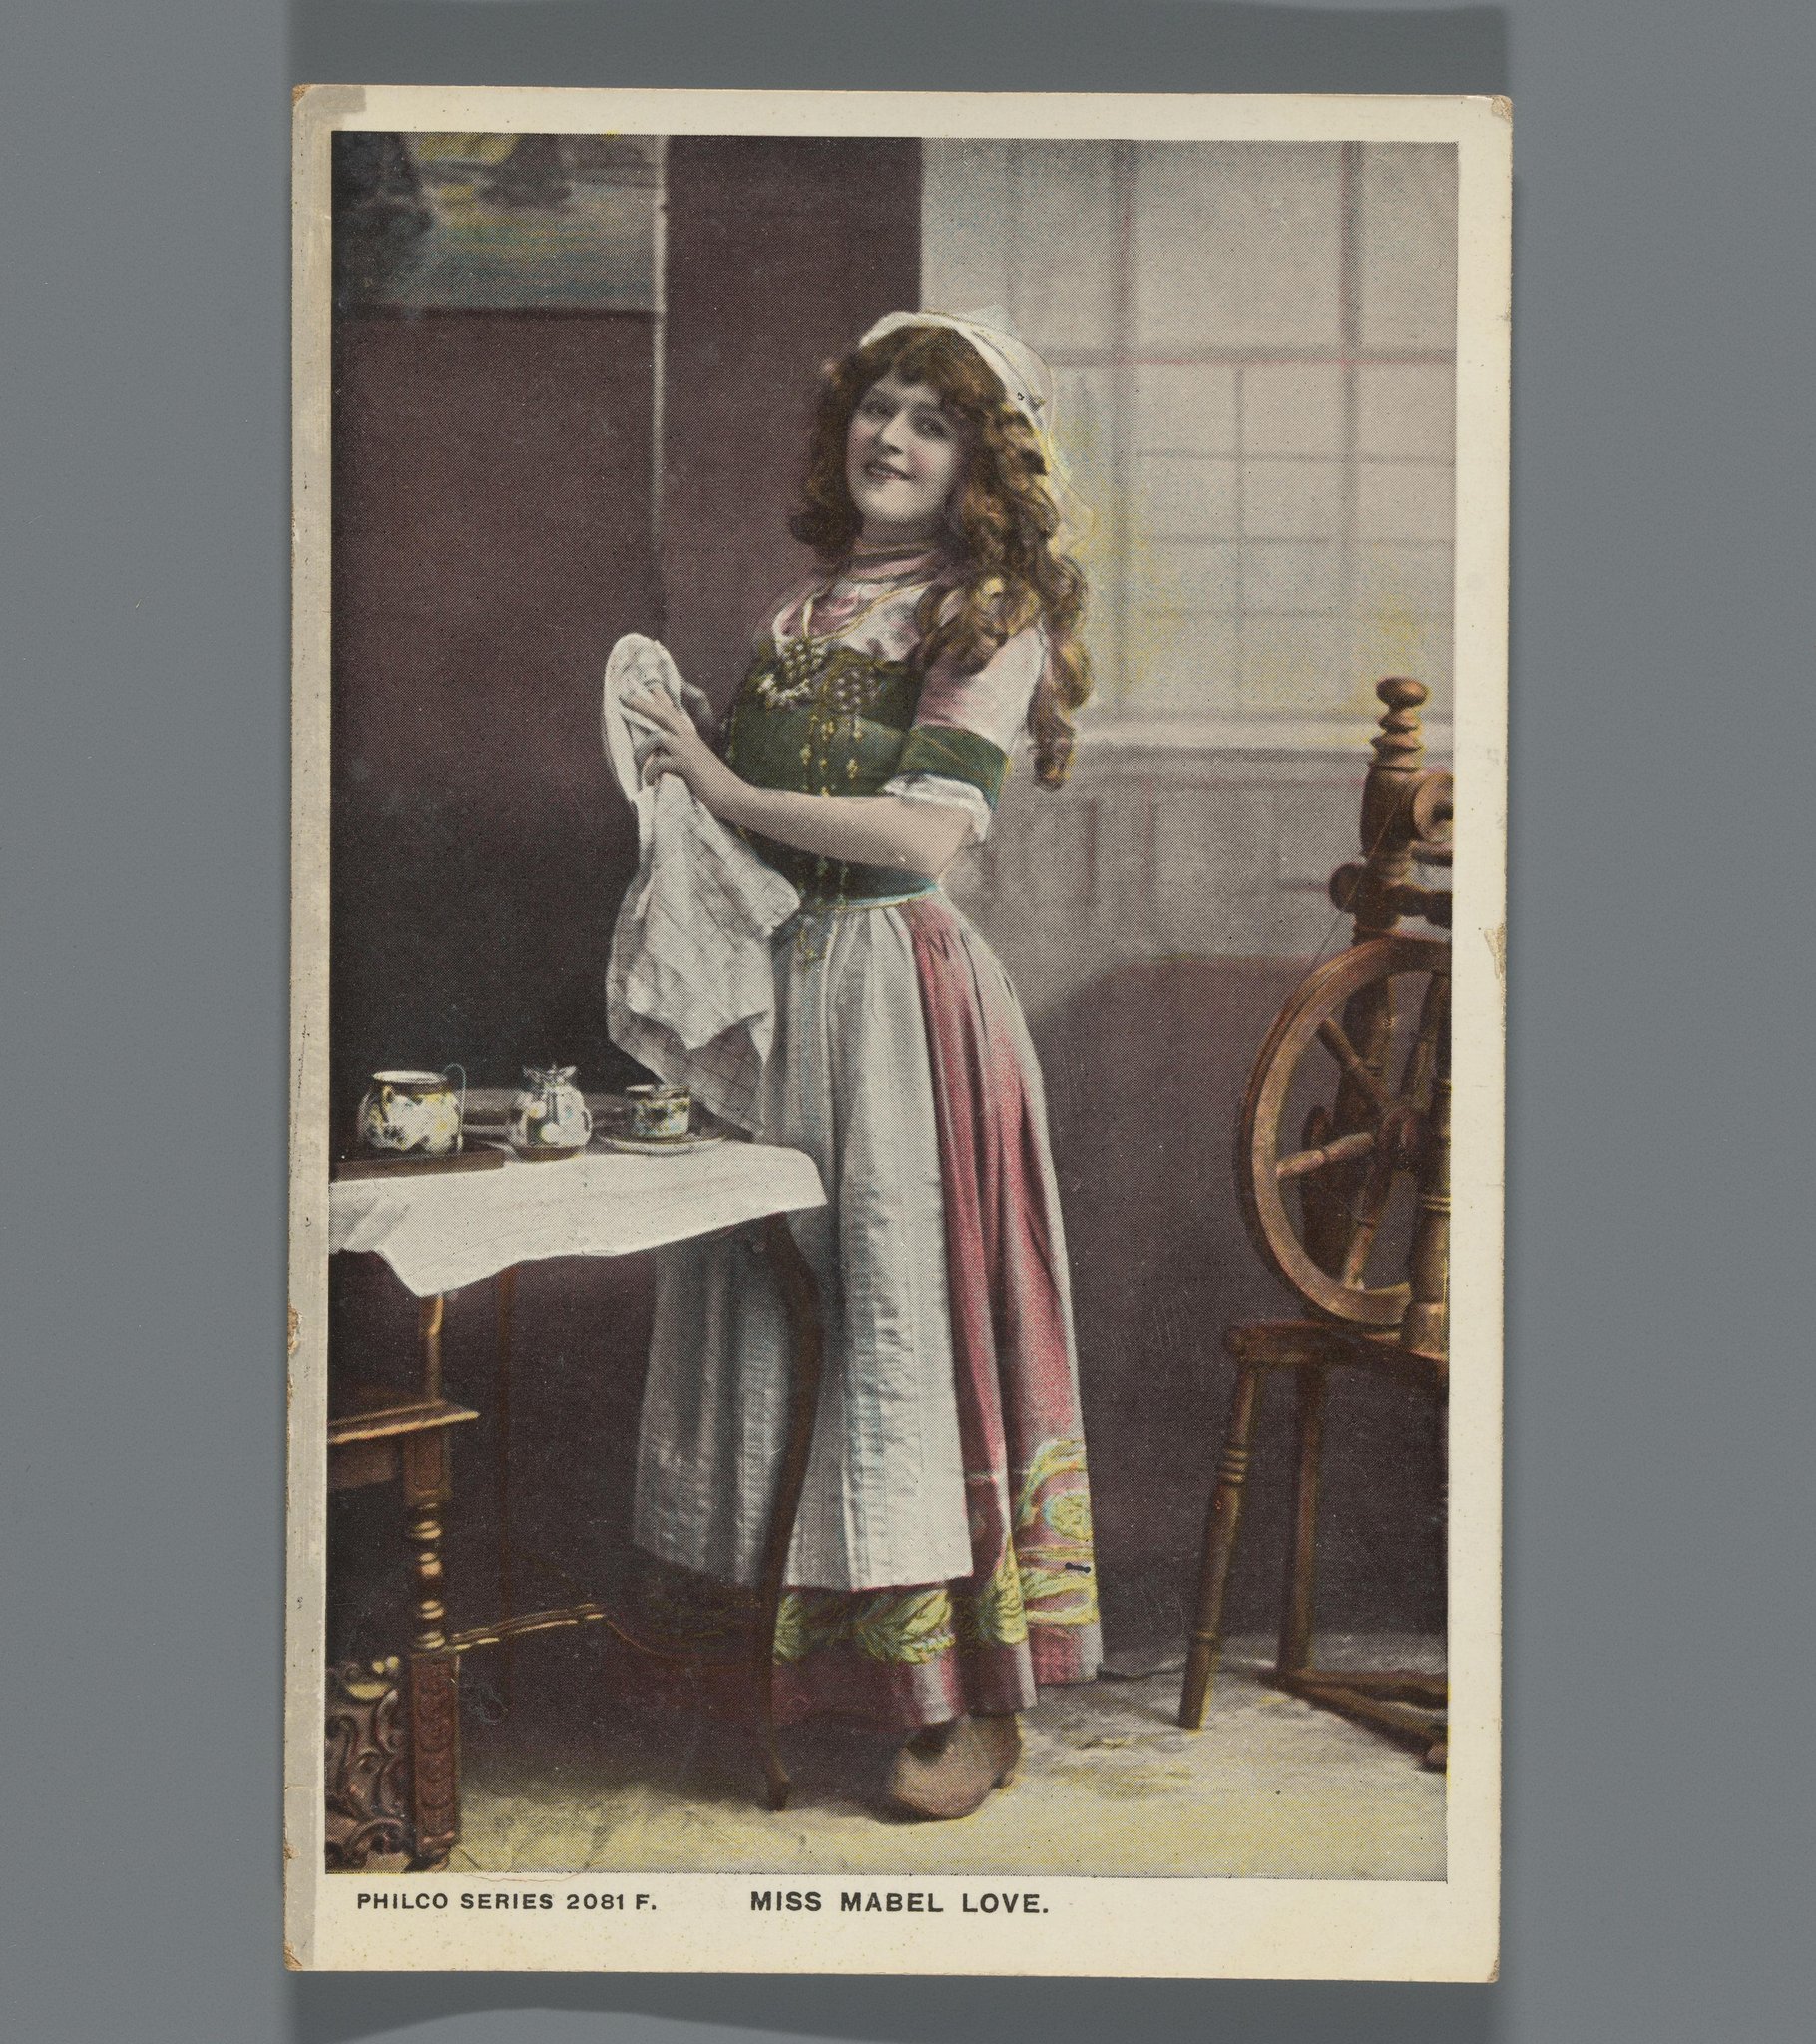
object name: photomechanical print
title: Portret van Mabel Love als dienstmeid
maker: Anonymous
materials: ink, paper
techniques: lithograph, pen, writing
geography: london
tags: portrait of actor, actress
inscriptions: address: ‘The Philco Publishing Co., Holborn Place, London, W.C.’, inscription: ‘Moeder/ Mej. Anna van Aalst/ Kerk-Avezaath’, number: ‘PHILCO SERIES 2081 F.’